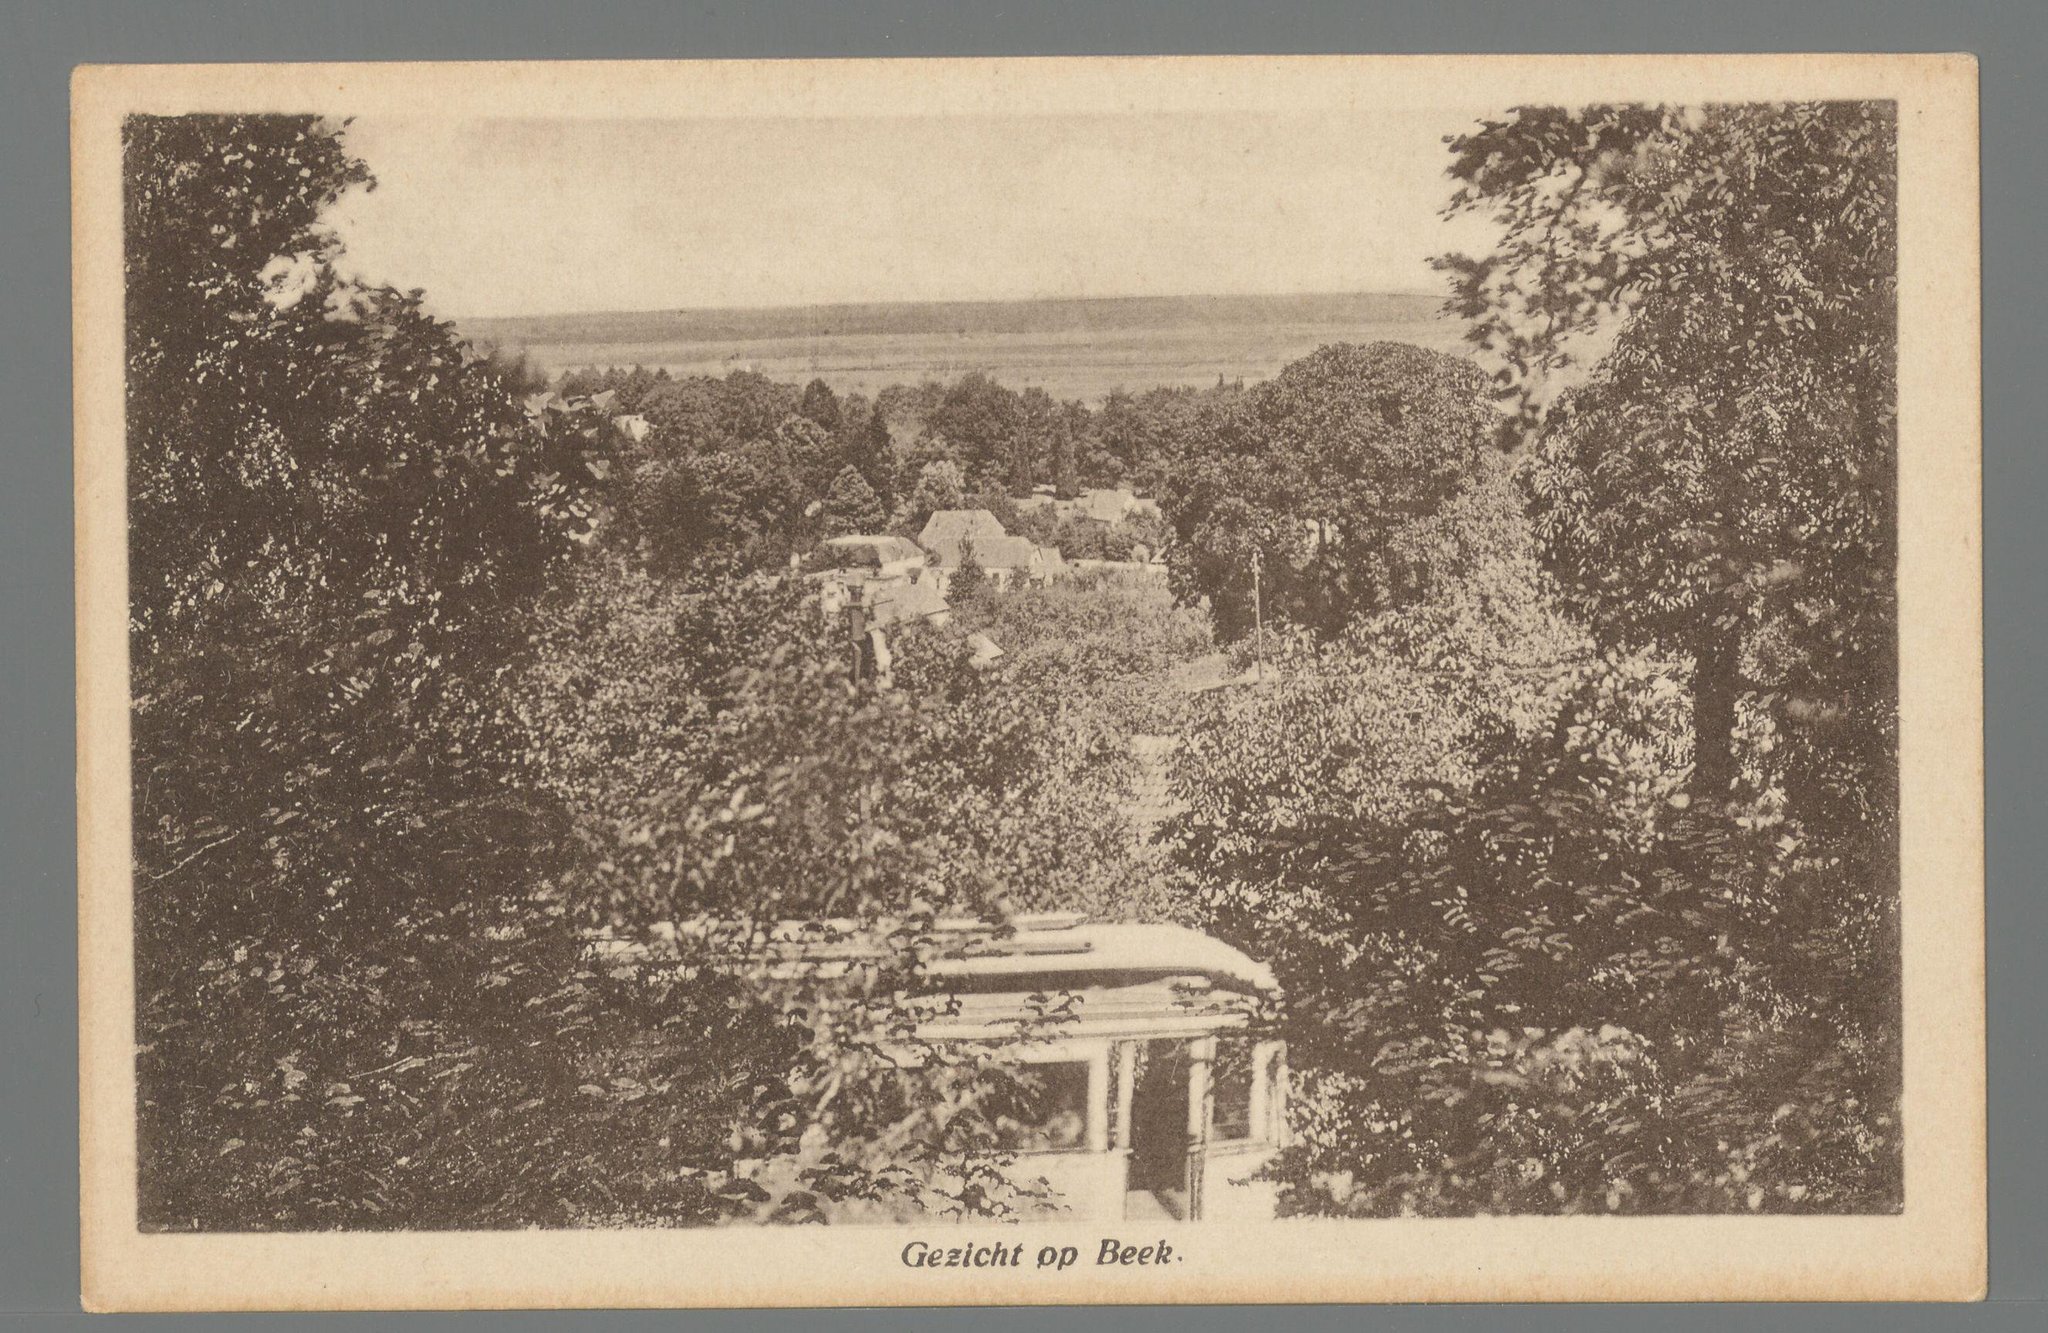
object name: ansichtkaart, prentbriefkaart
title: Gezicht op Beek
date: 1913-1930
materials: cardboard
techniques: photograph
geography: plasmolen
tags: prospect of city, town panorama, silhouette of city